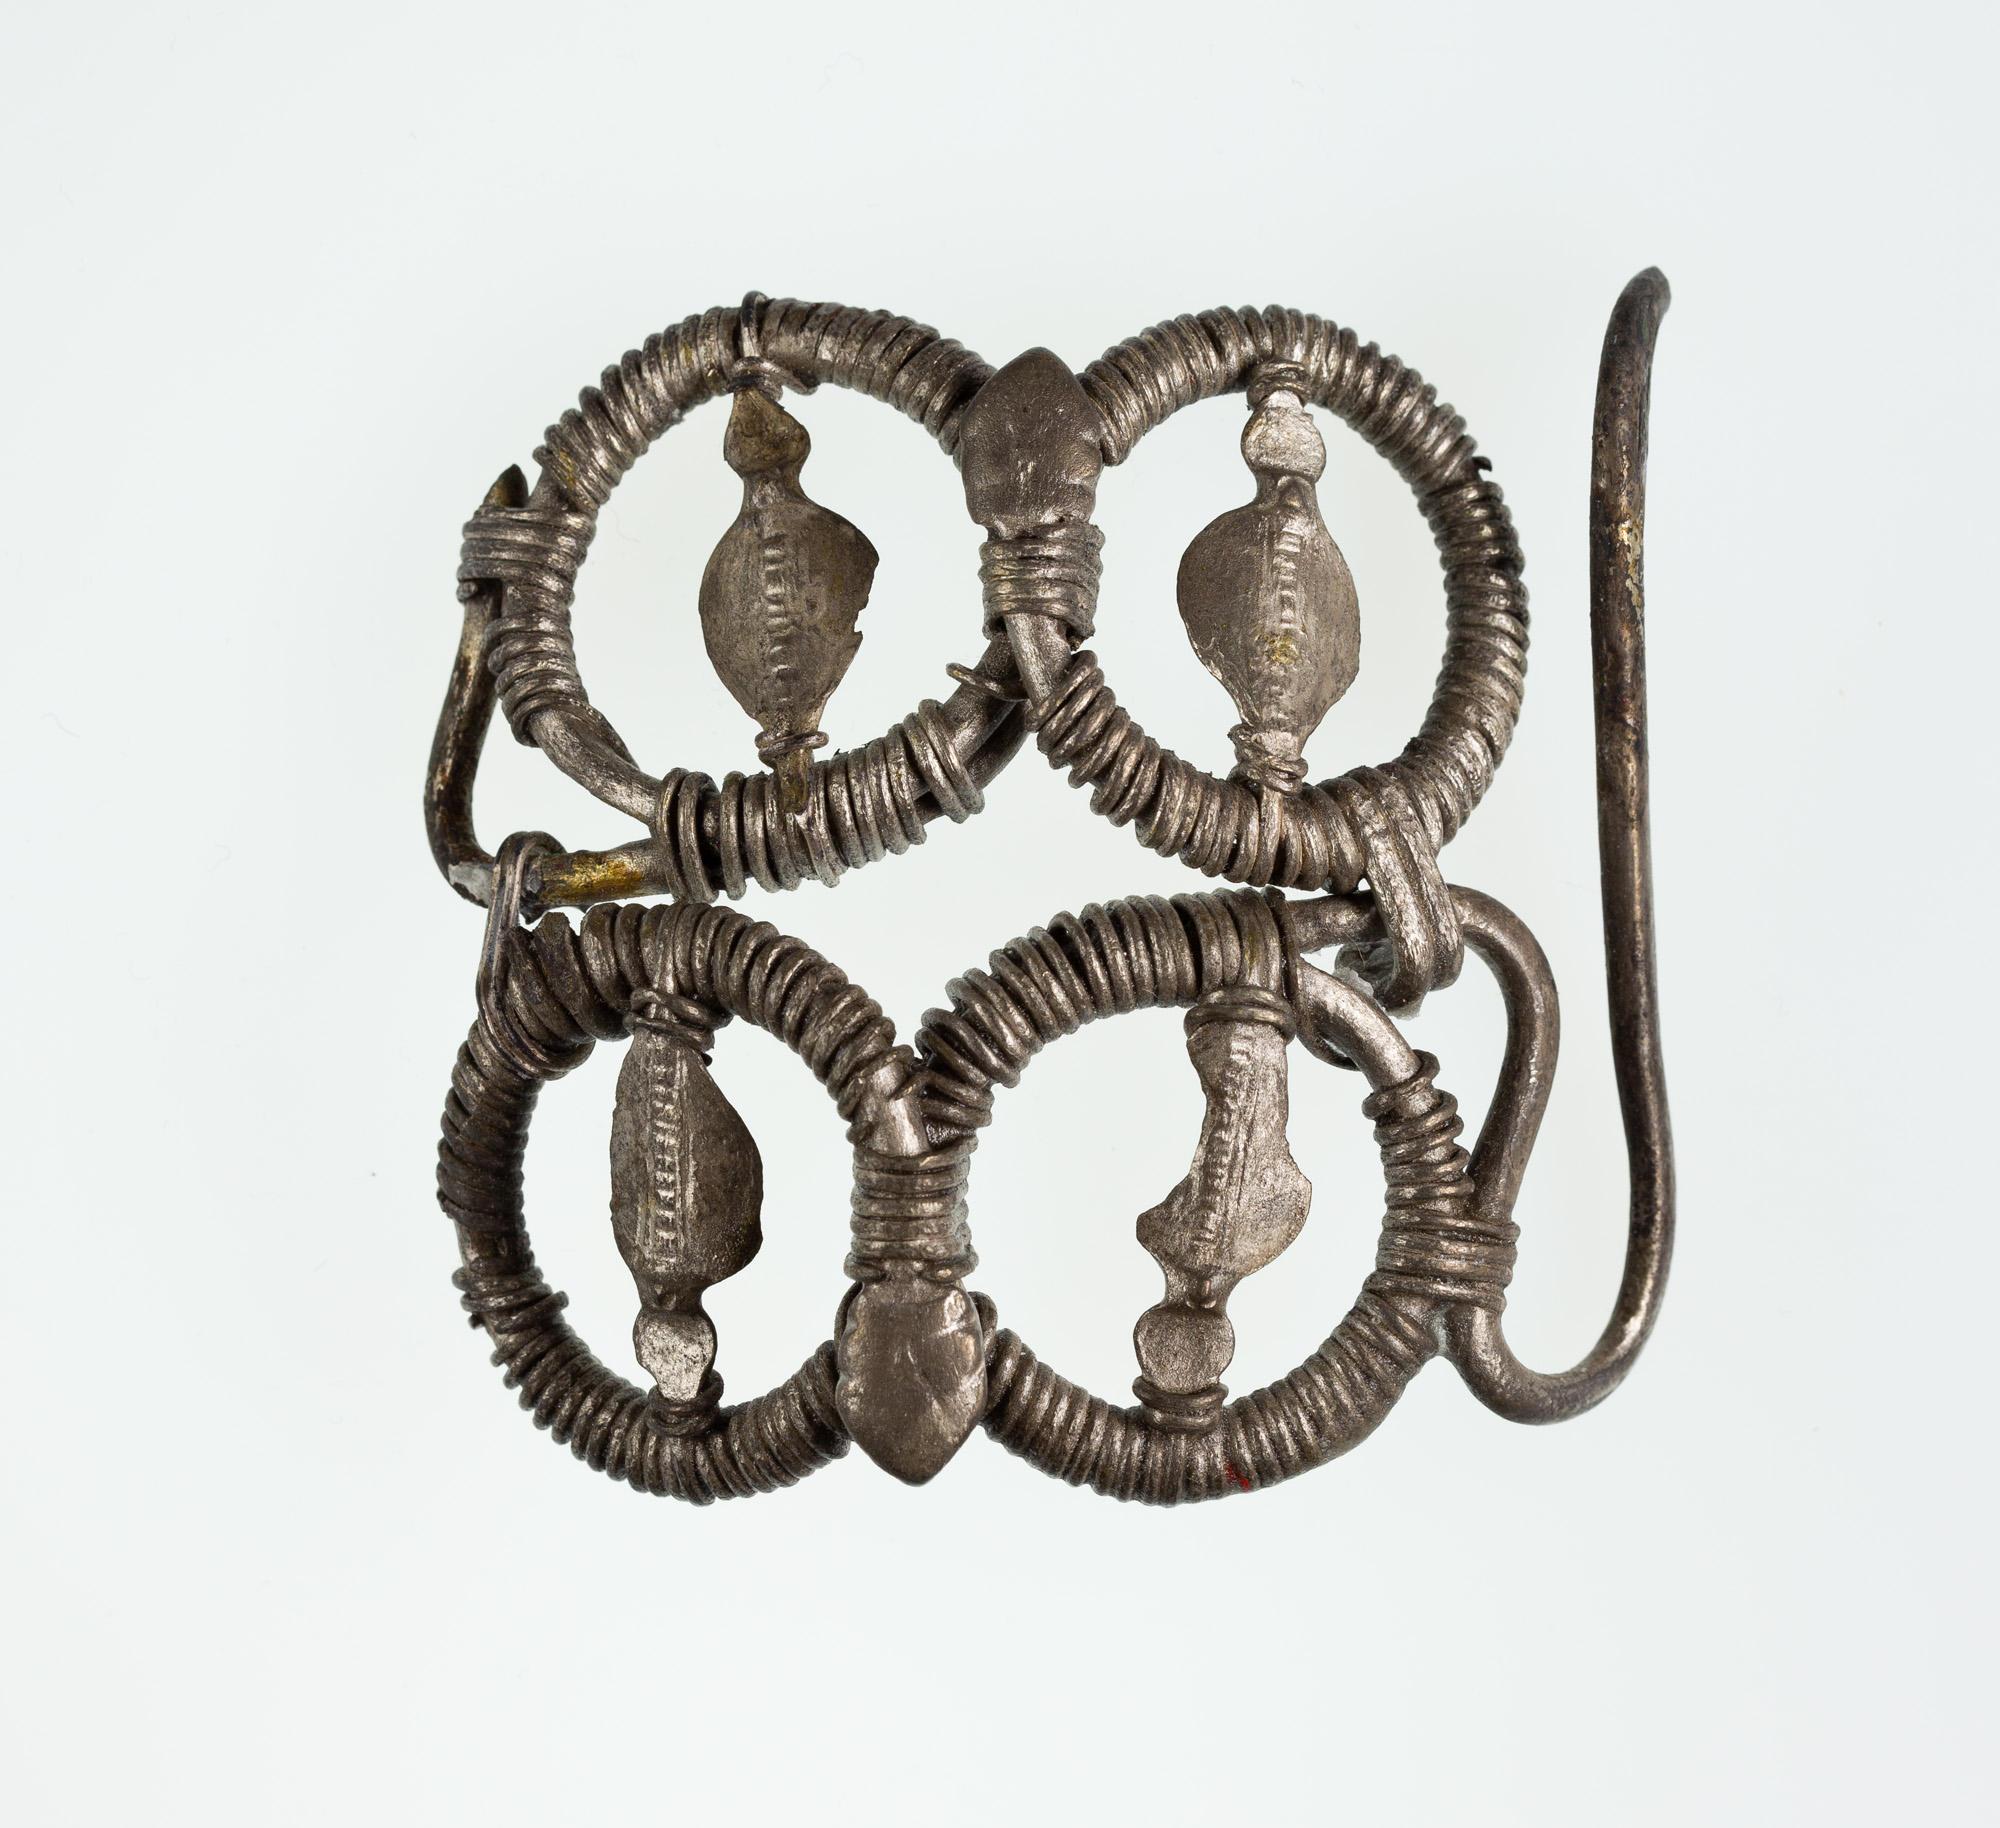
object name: bracelet or armlet, uraei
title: Part (?) of a bracelet or armlet with uraei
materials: silver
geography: egypt